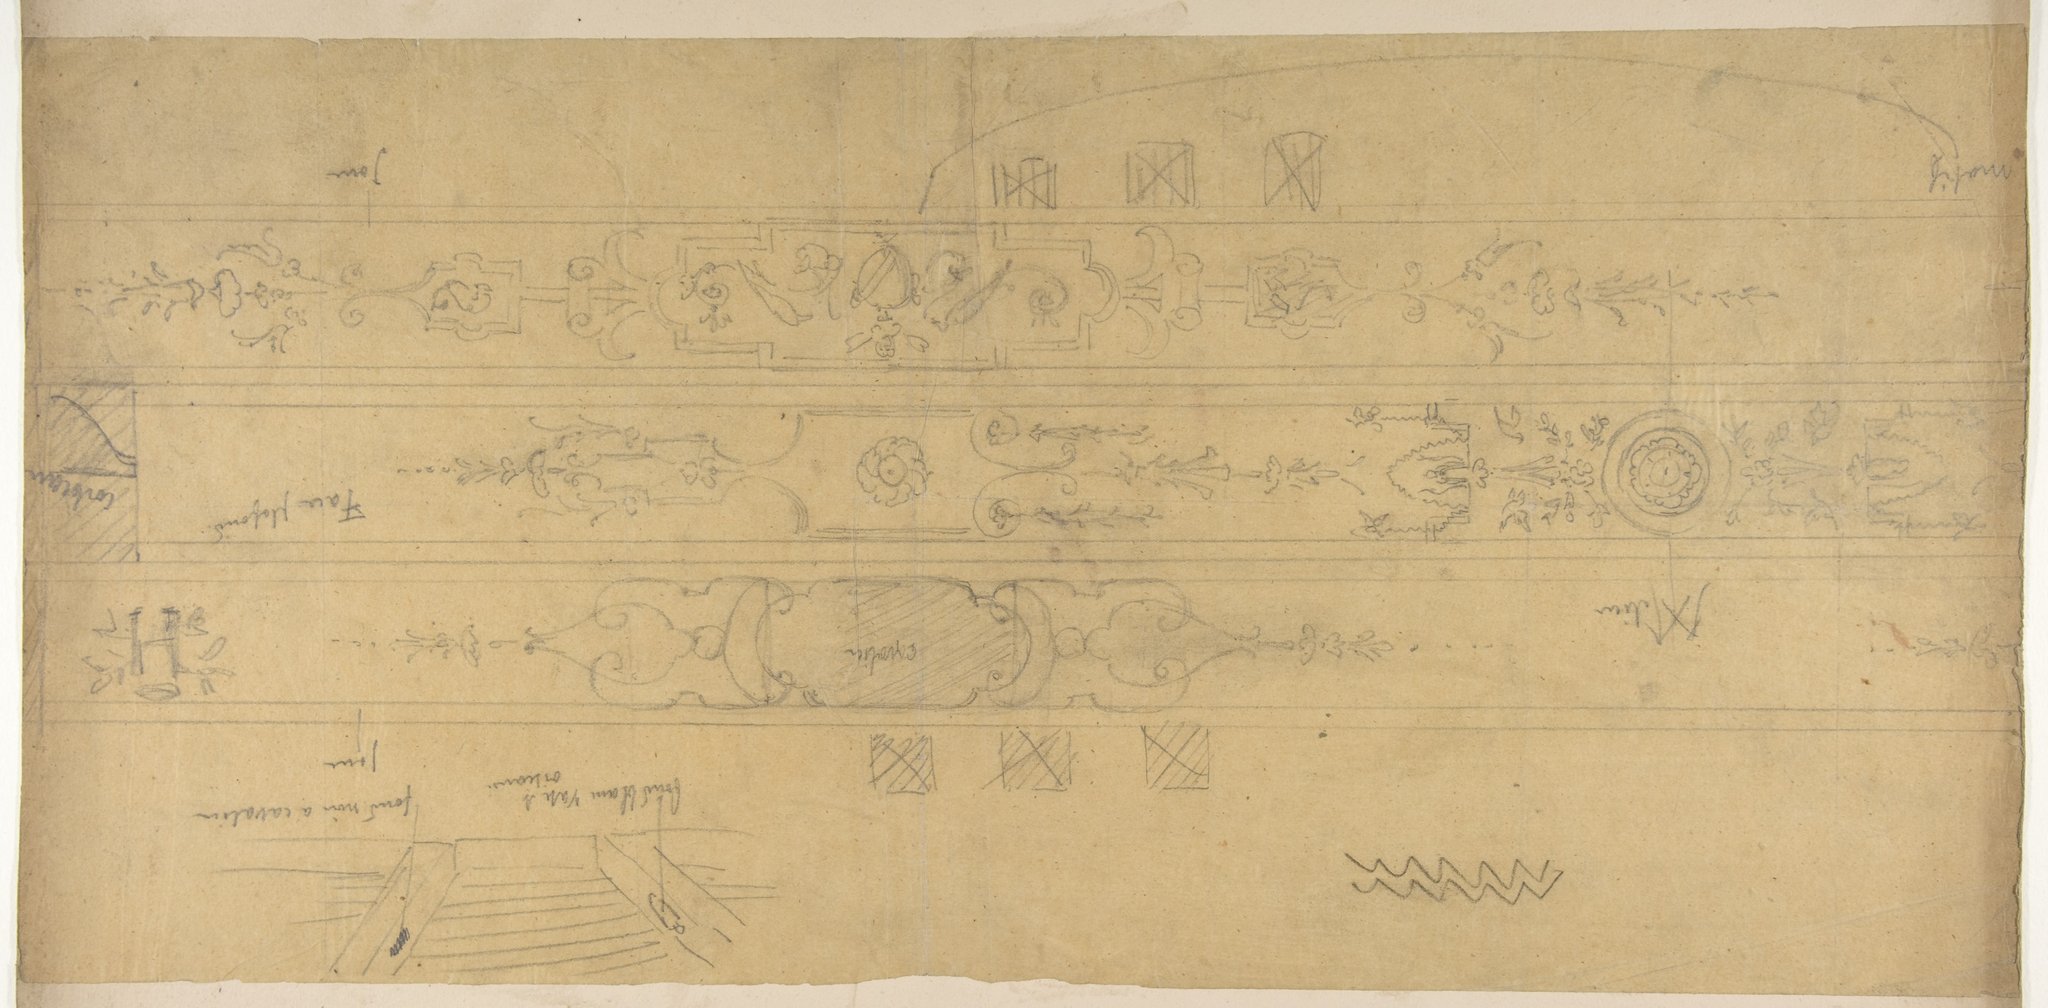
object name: drawing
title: Design for Ceiling Decorations, Fontainebleau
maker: jules-edmond-charles lachaise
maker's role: artist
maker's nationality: french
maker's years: 1897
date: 1851-1900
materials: graphite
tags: flowers